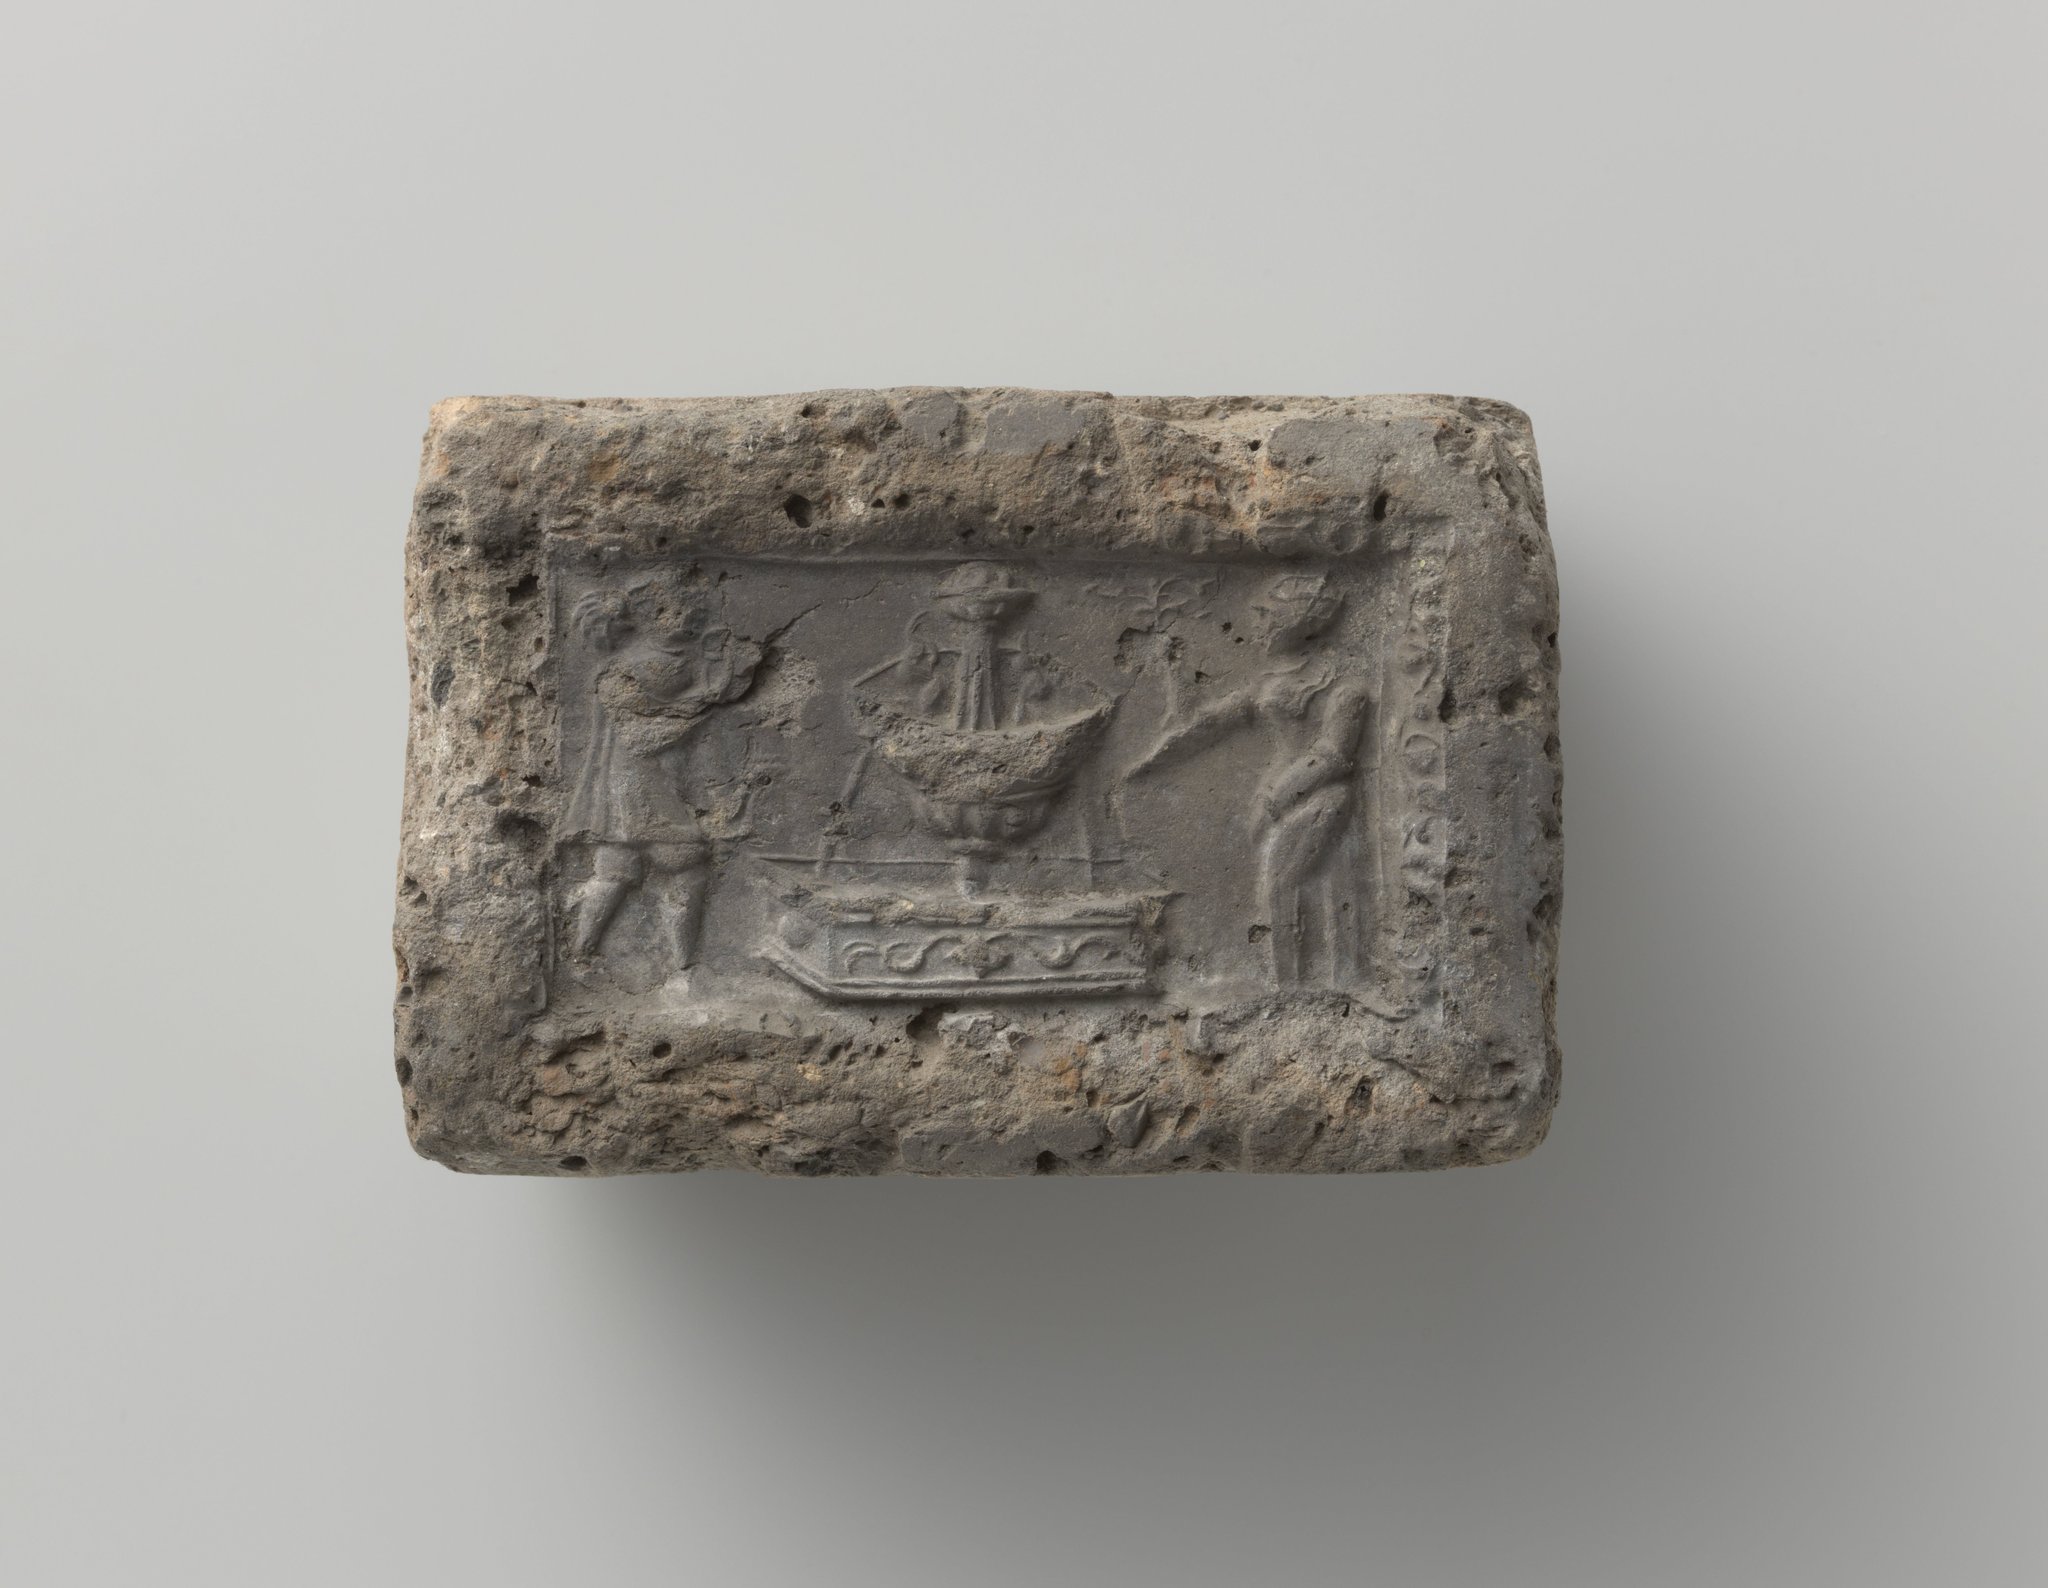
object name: hearthstone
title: Haardsteen met afbeelding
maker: Anonymous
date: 1580-1600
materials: earthenware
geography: southern netherlands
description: Haardsteen met ruiten, voorstellende een fontein, aan weerzijde een staande man en vrouw.